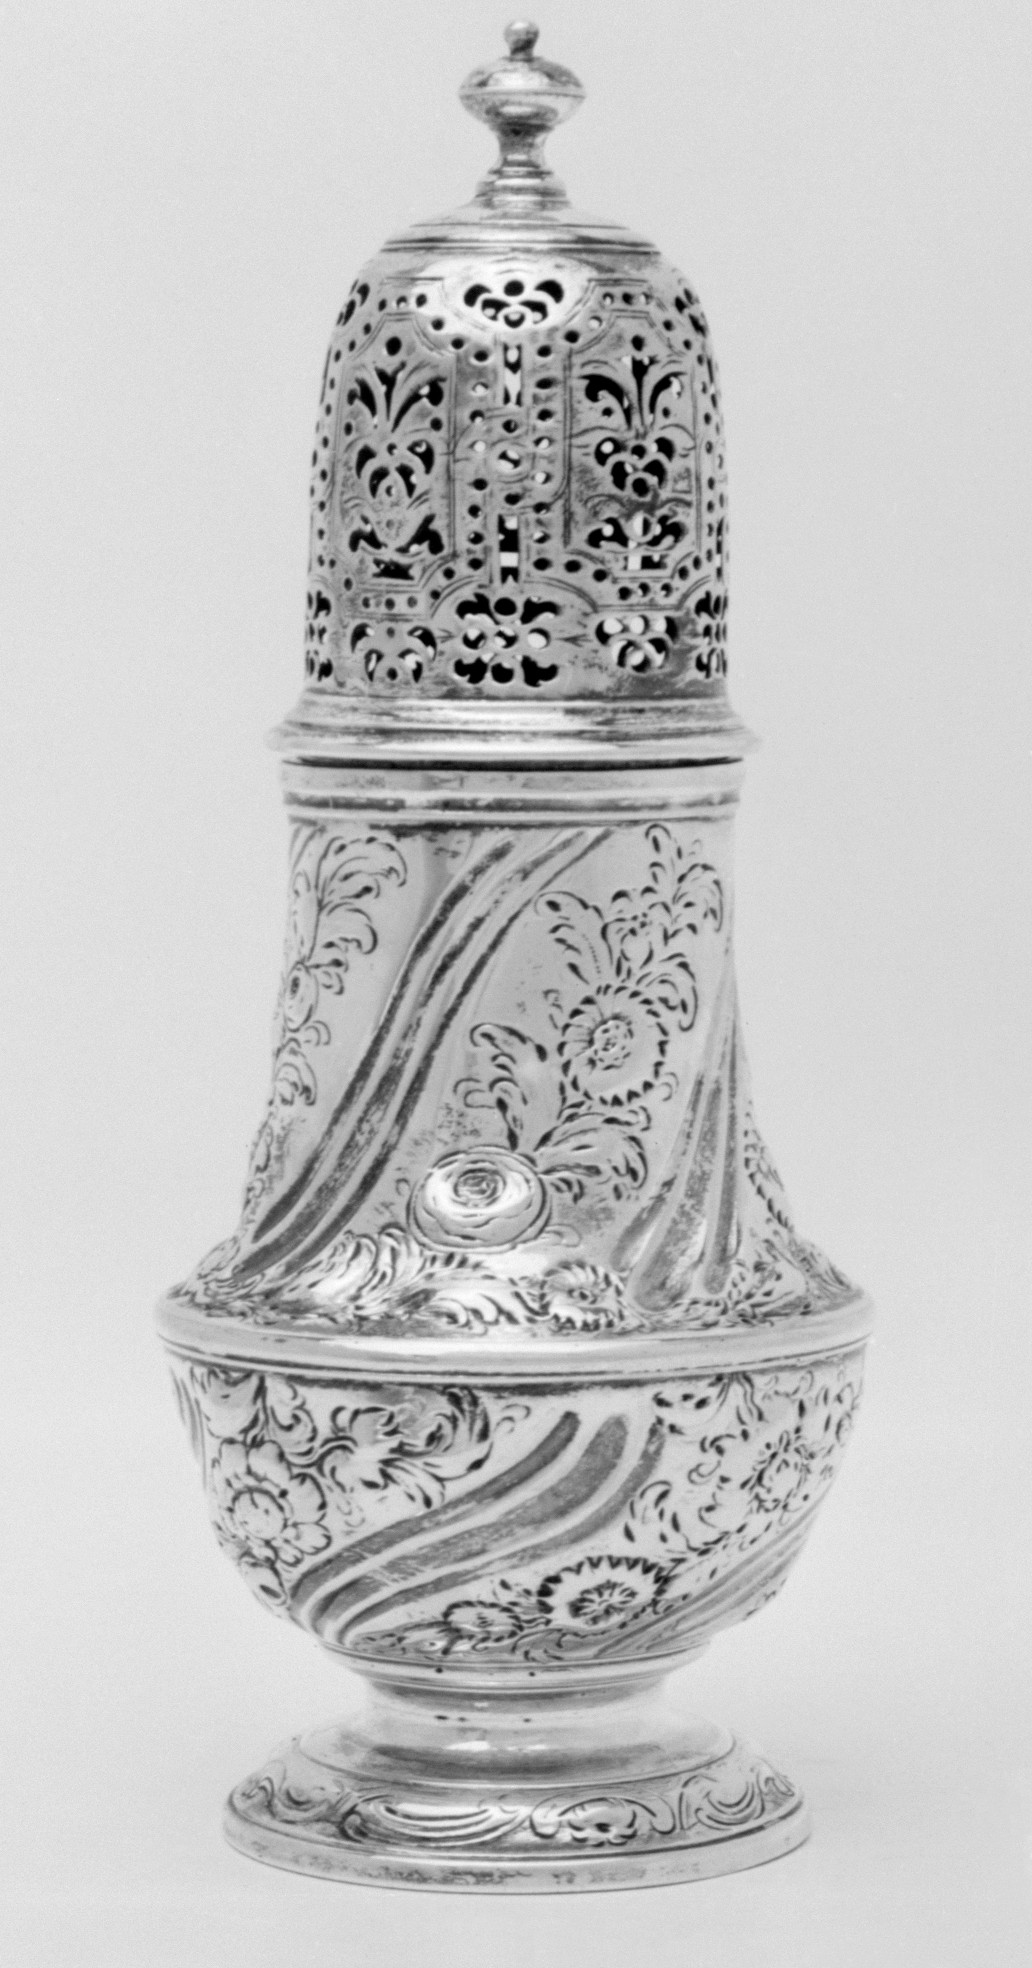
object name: caster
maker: starling wilford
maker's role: maker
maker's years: 1720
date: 1726-1727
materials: silver